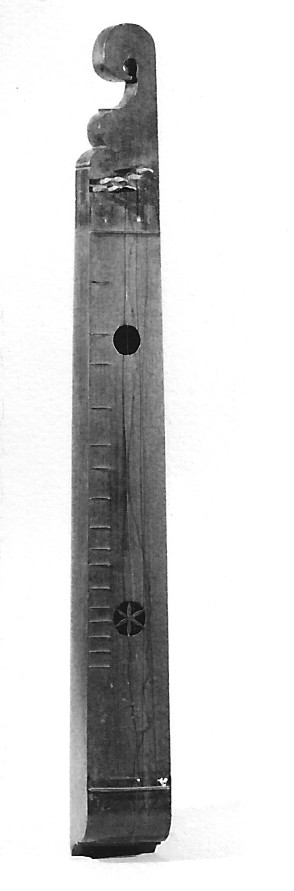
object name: zither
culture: european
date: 1767-1866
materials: metal, wood